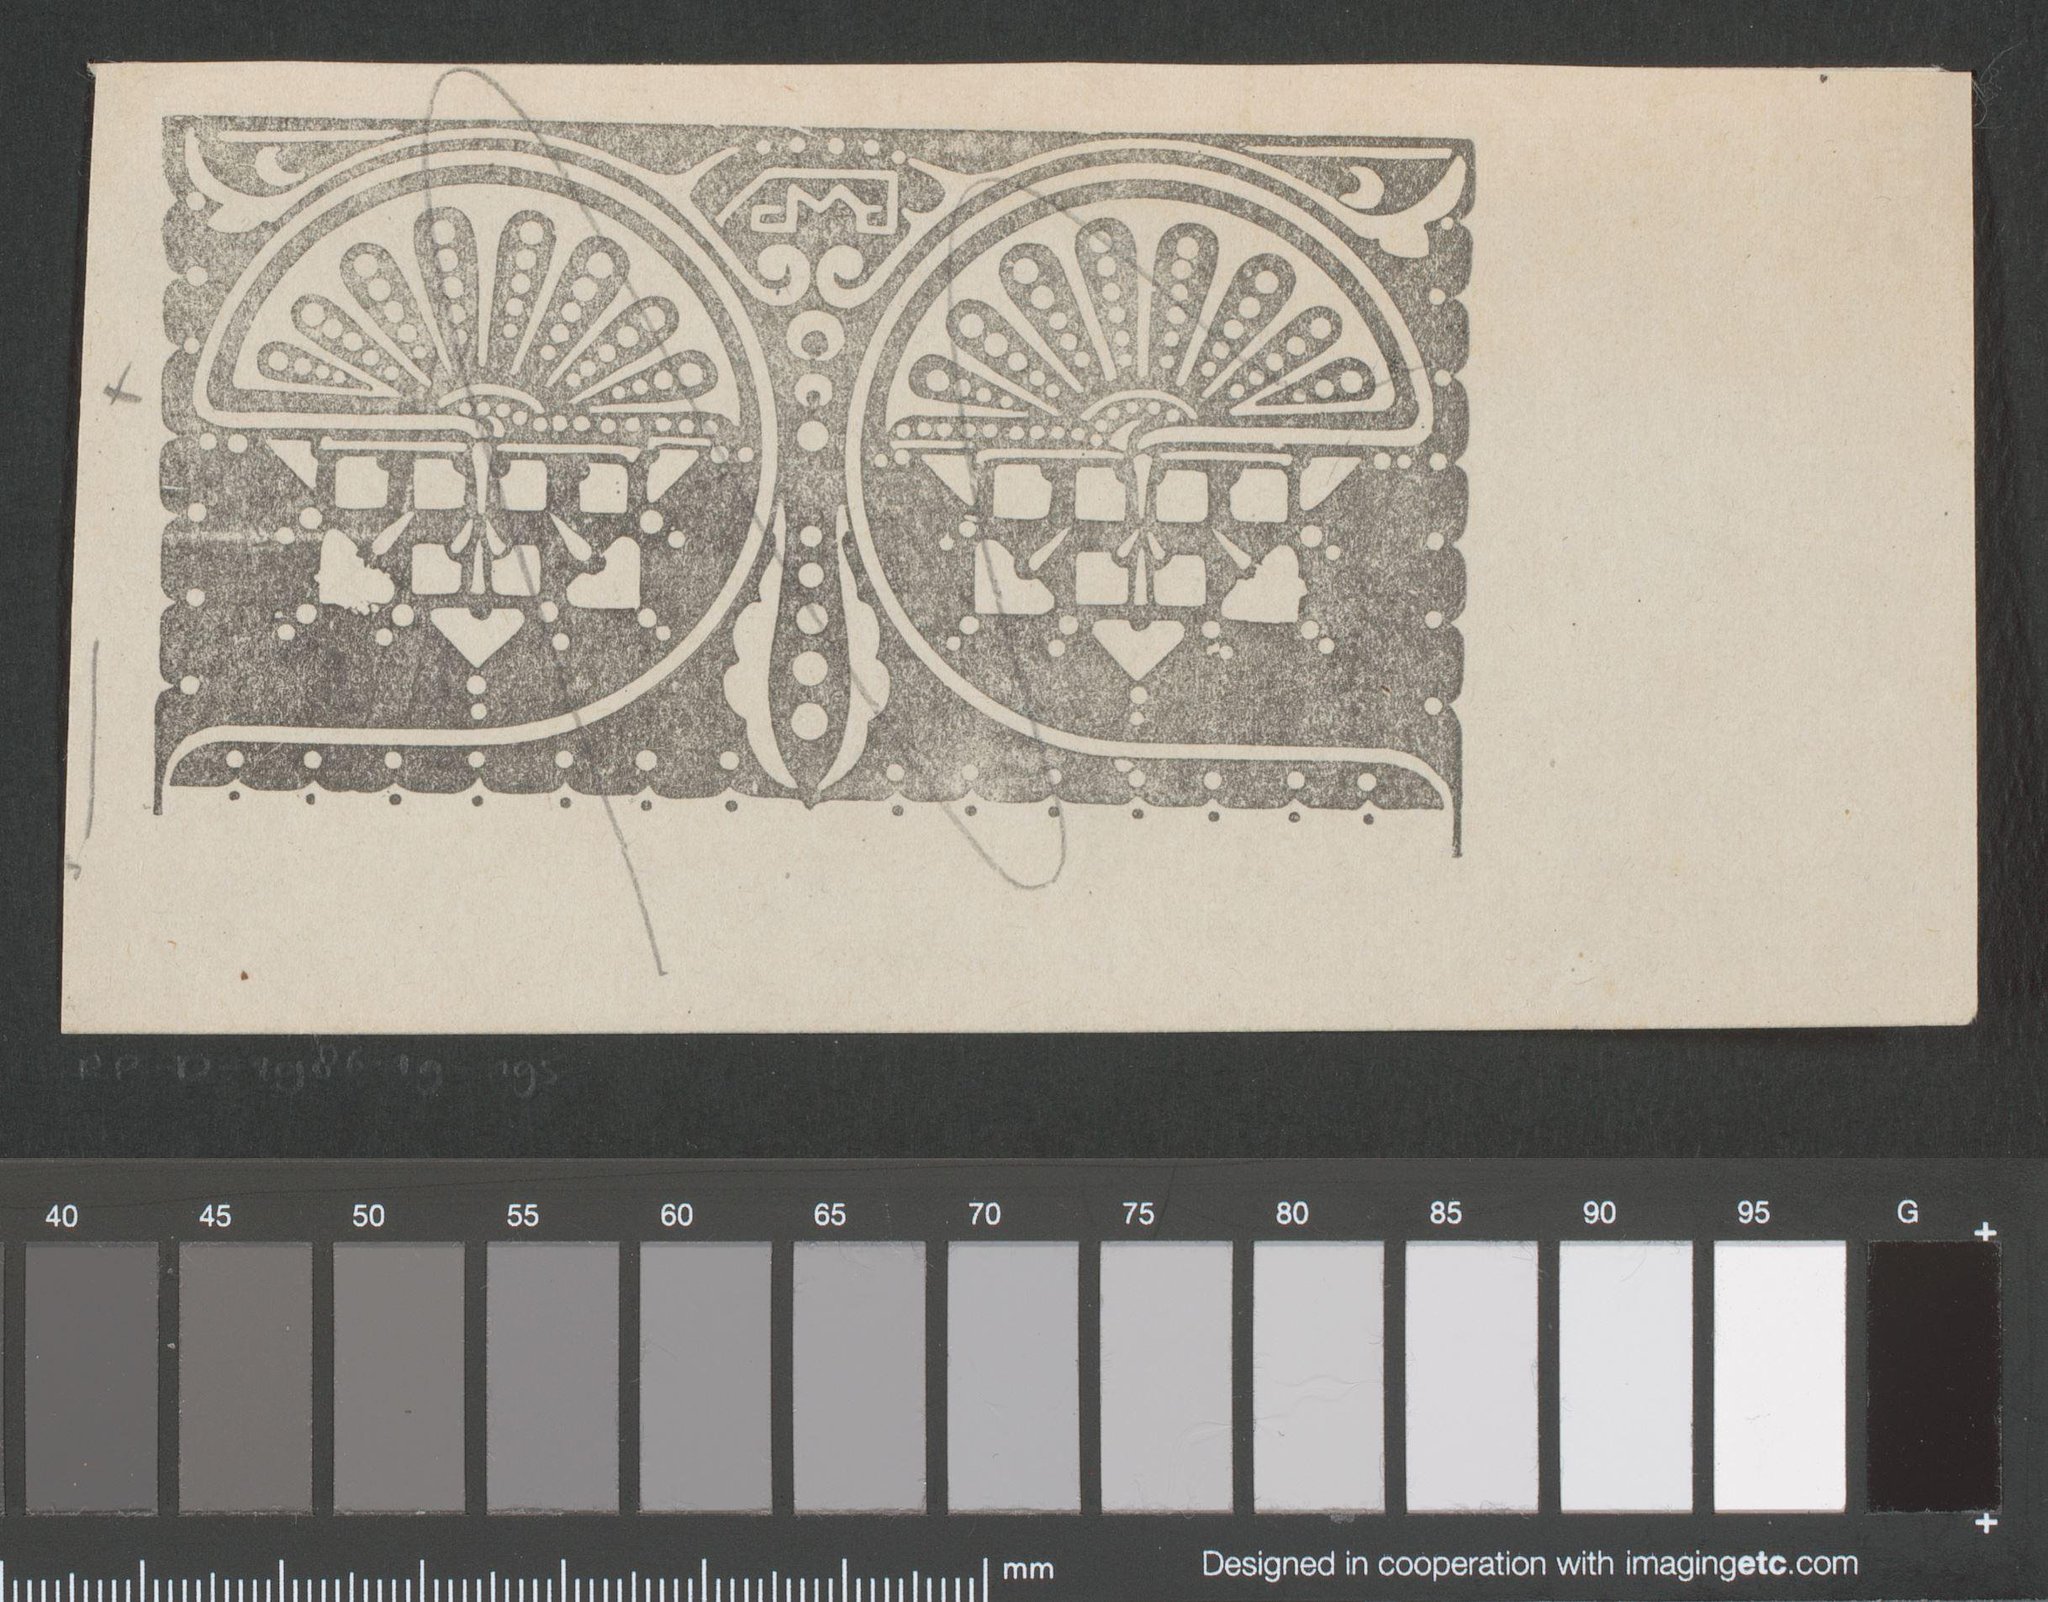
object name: print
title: Patroon met halve cirkels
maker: reinier willem petrus de vries (1874-1953)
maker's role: draughtsman, print maker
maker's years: 1874-1953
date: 1884-1952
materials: paper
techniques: relief print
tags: ornaments ~ art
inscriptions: collector's mark: ‘R:MVS.’